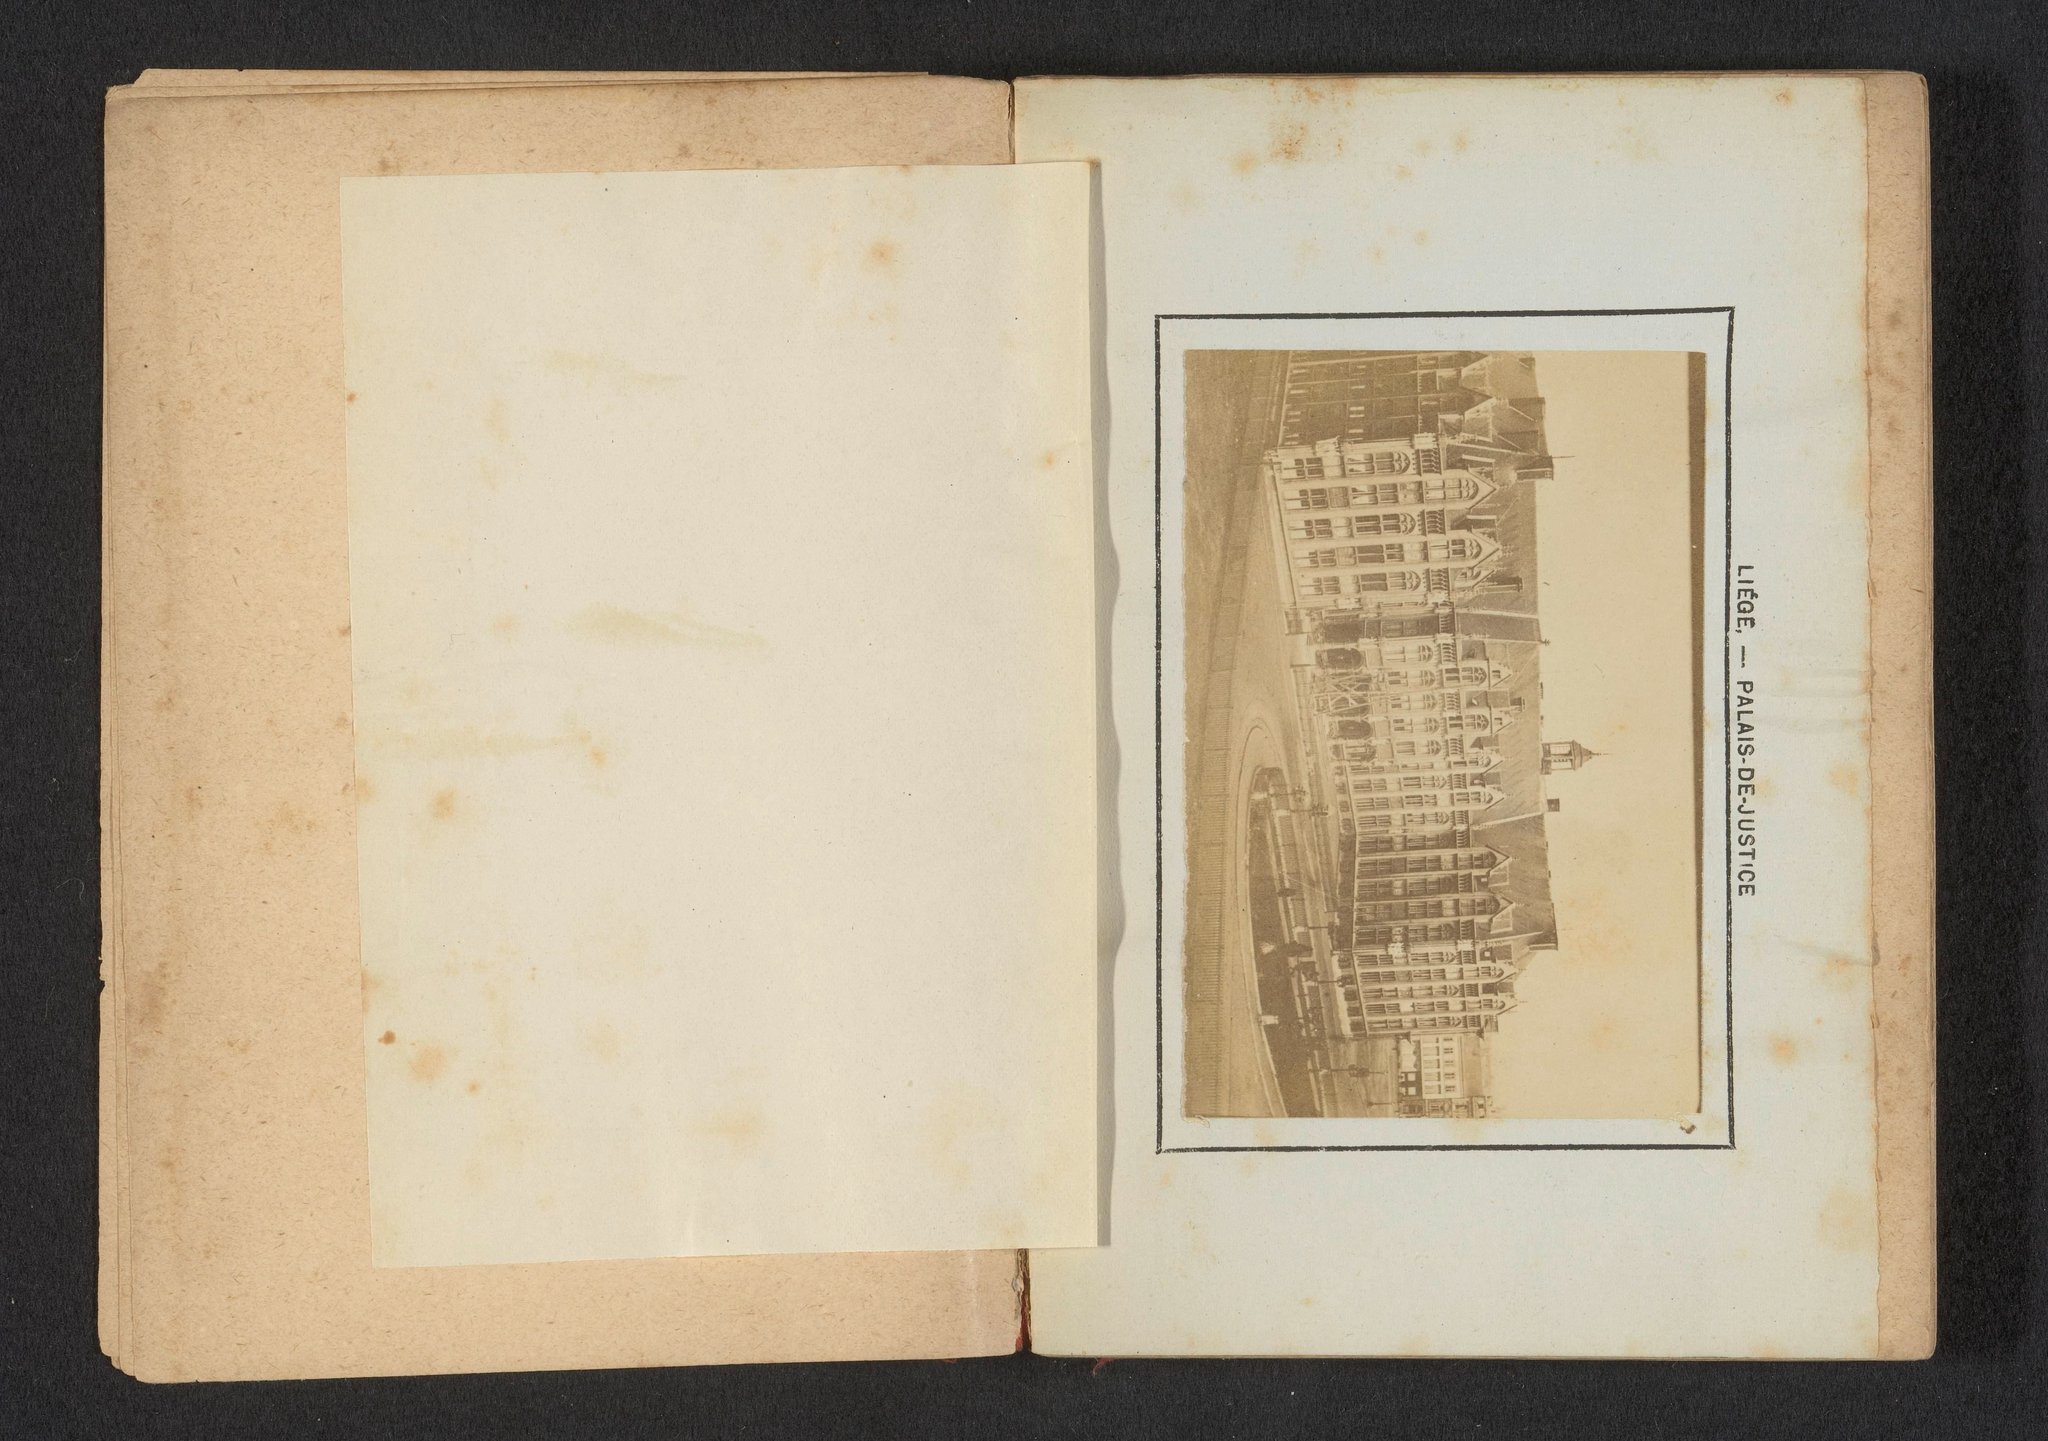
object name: photograph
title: Liège, Palais de Justice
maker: Anonymous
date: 1876-1881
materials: photographic support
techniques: albumen print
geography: liège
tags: court building, façade (of house or building)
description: Foto op derde ongenummerde pagina na titelpagina.